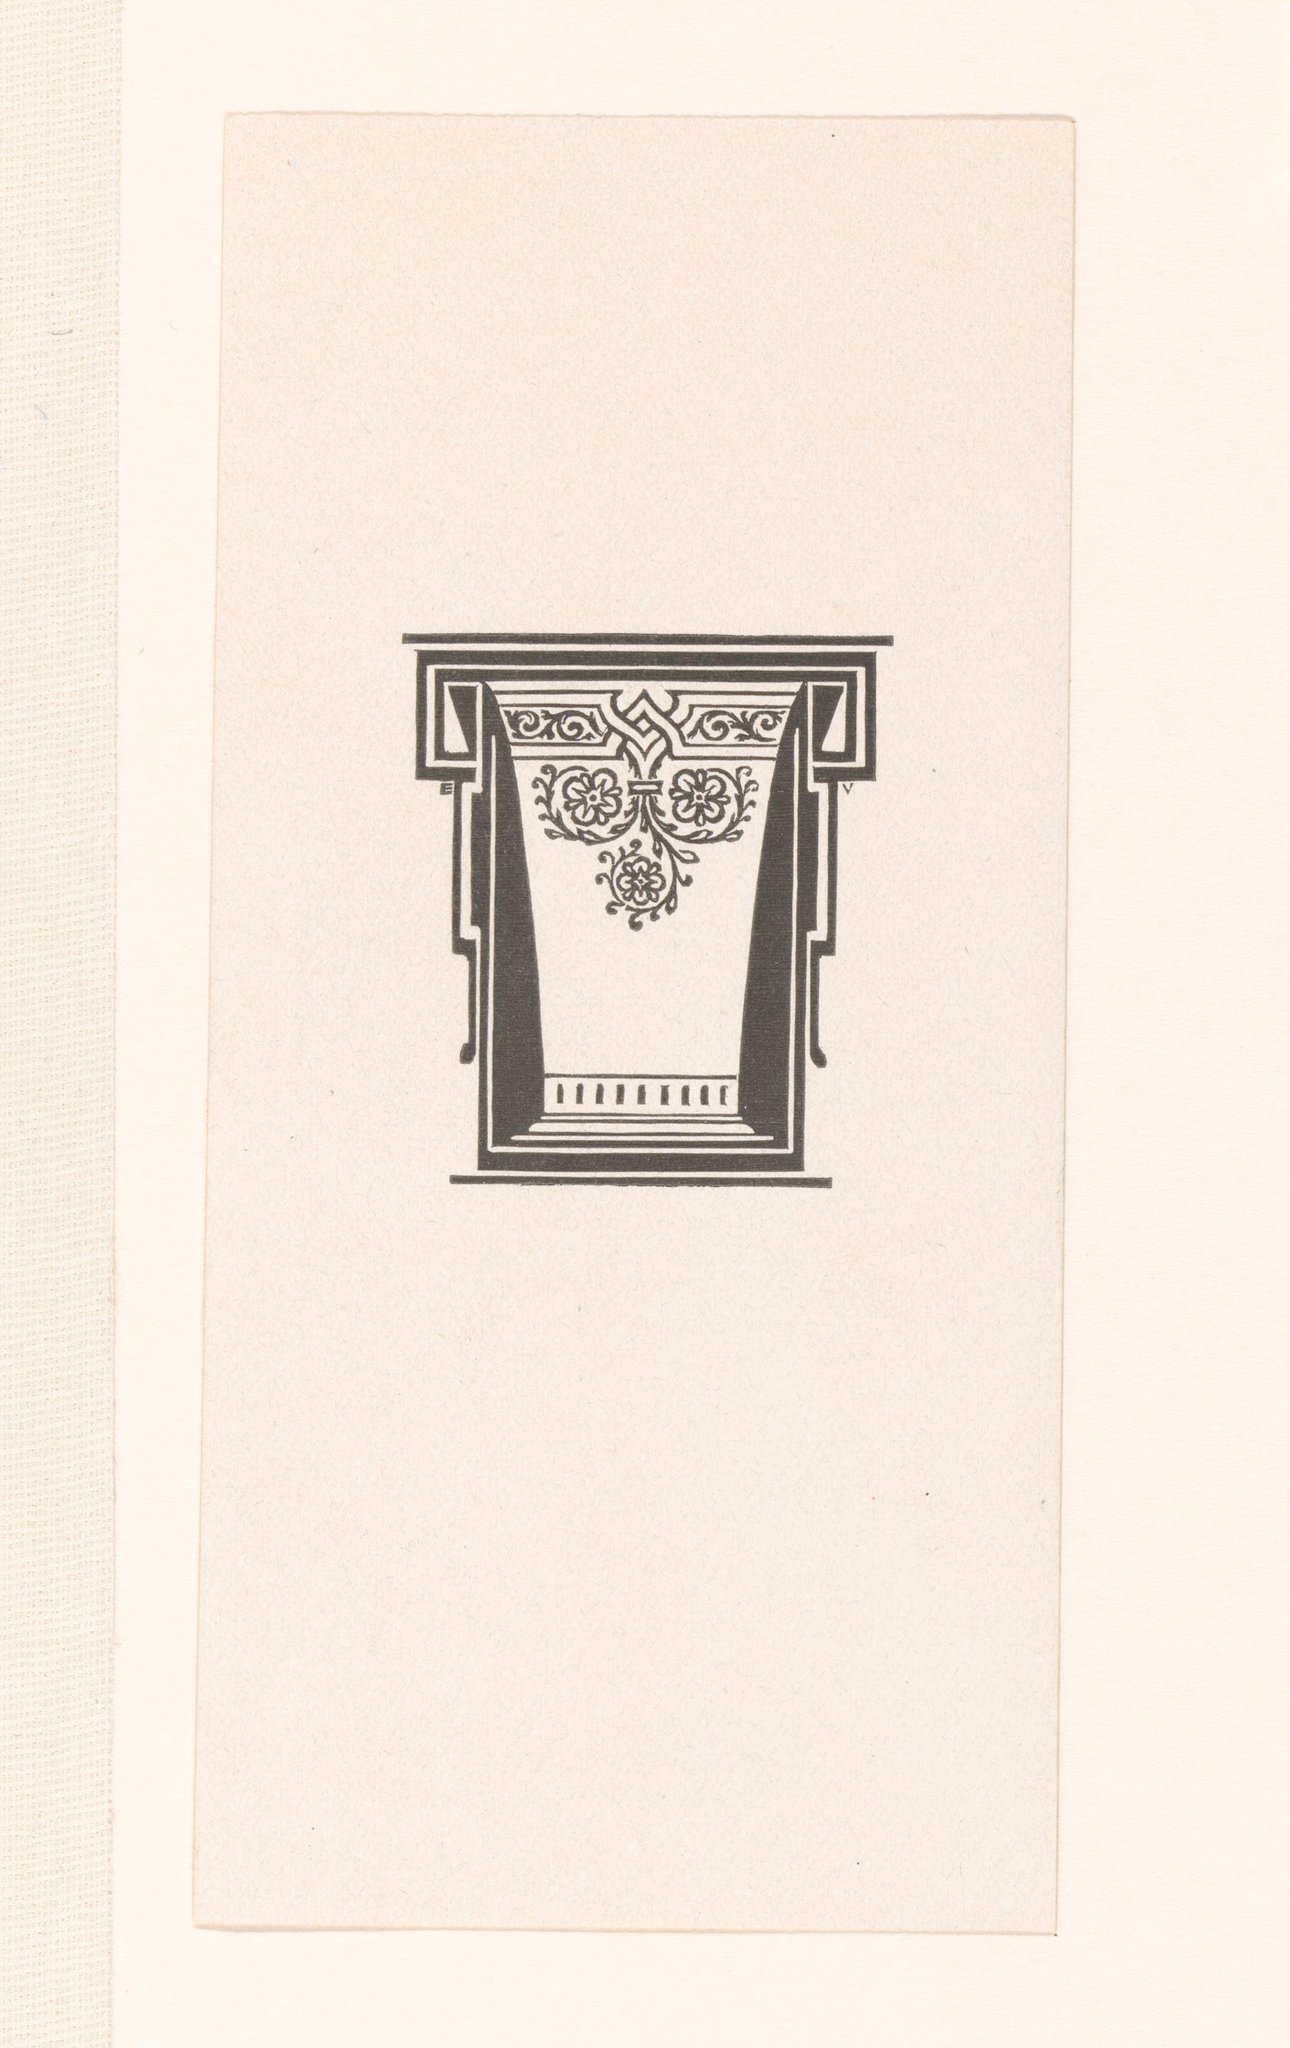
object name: print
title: Vignet met sokkel met bloemmotieven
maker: elias voet jr.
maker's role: jeweler, print maker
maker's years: 1868-1940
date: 1878-1940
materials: paper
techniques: woodcut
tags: pedestal of a piece of sculpture (perhaps in the form of a herm)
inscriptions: collector's mark: Lugt 2228